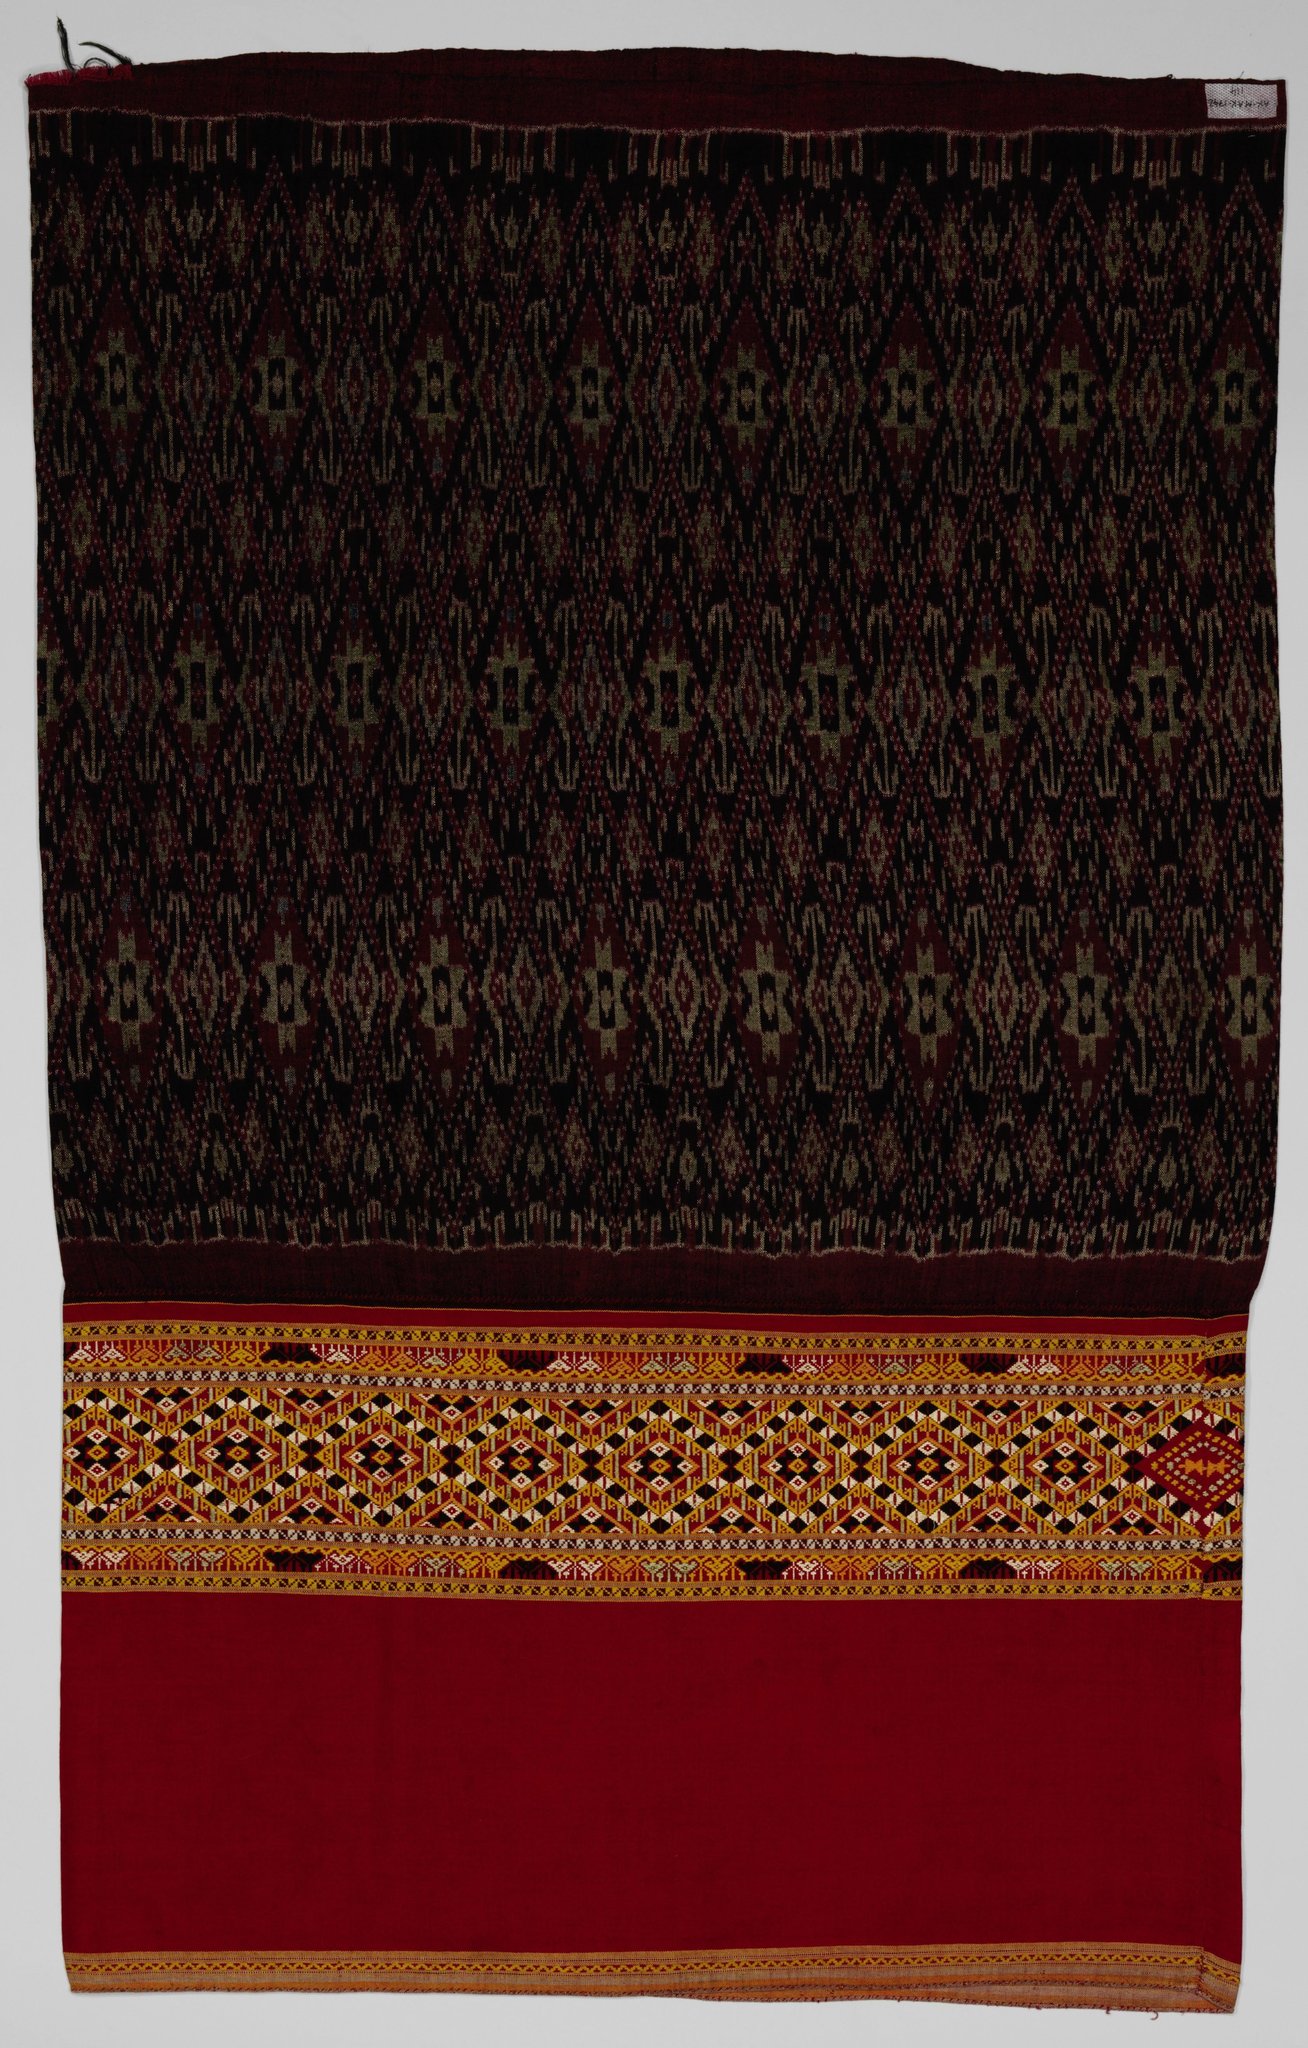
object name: cloth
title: Pa si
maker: Anonymous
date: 1900-1949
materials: silk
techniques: weave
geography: thailand